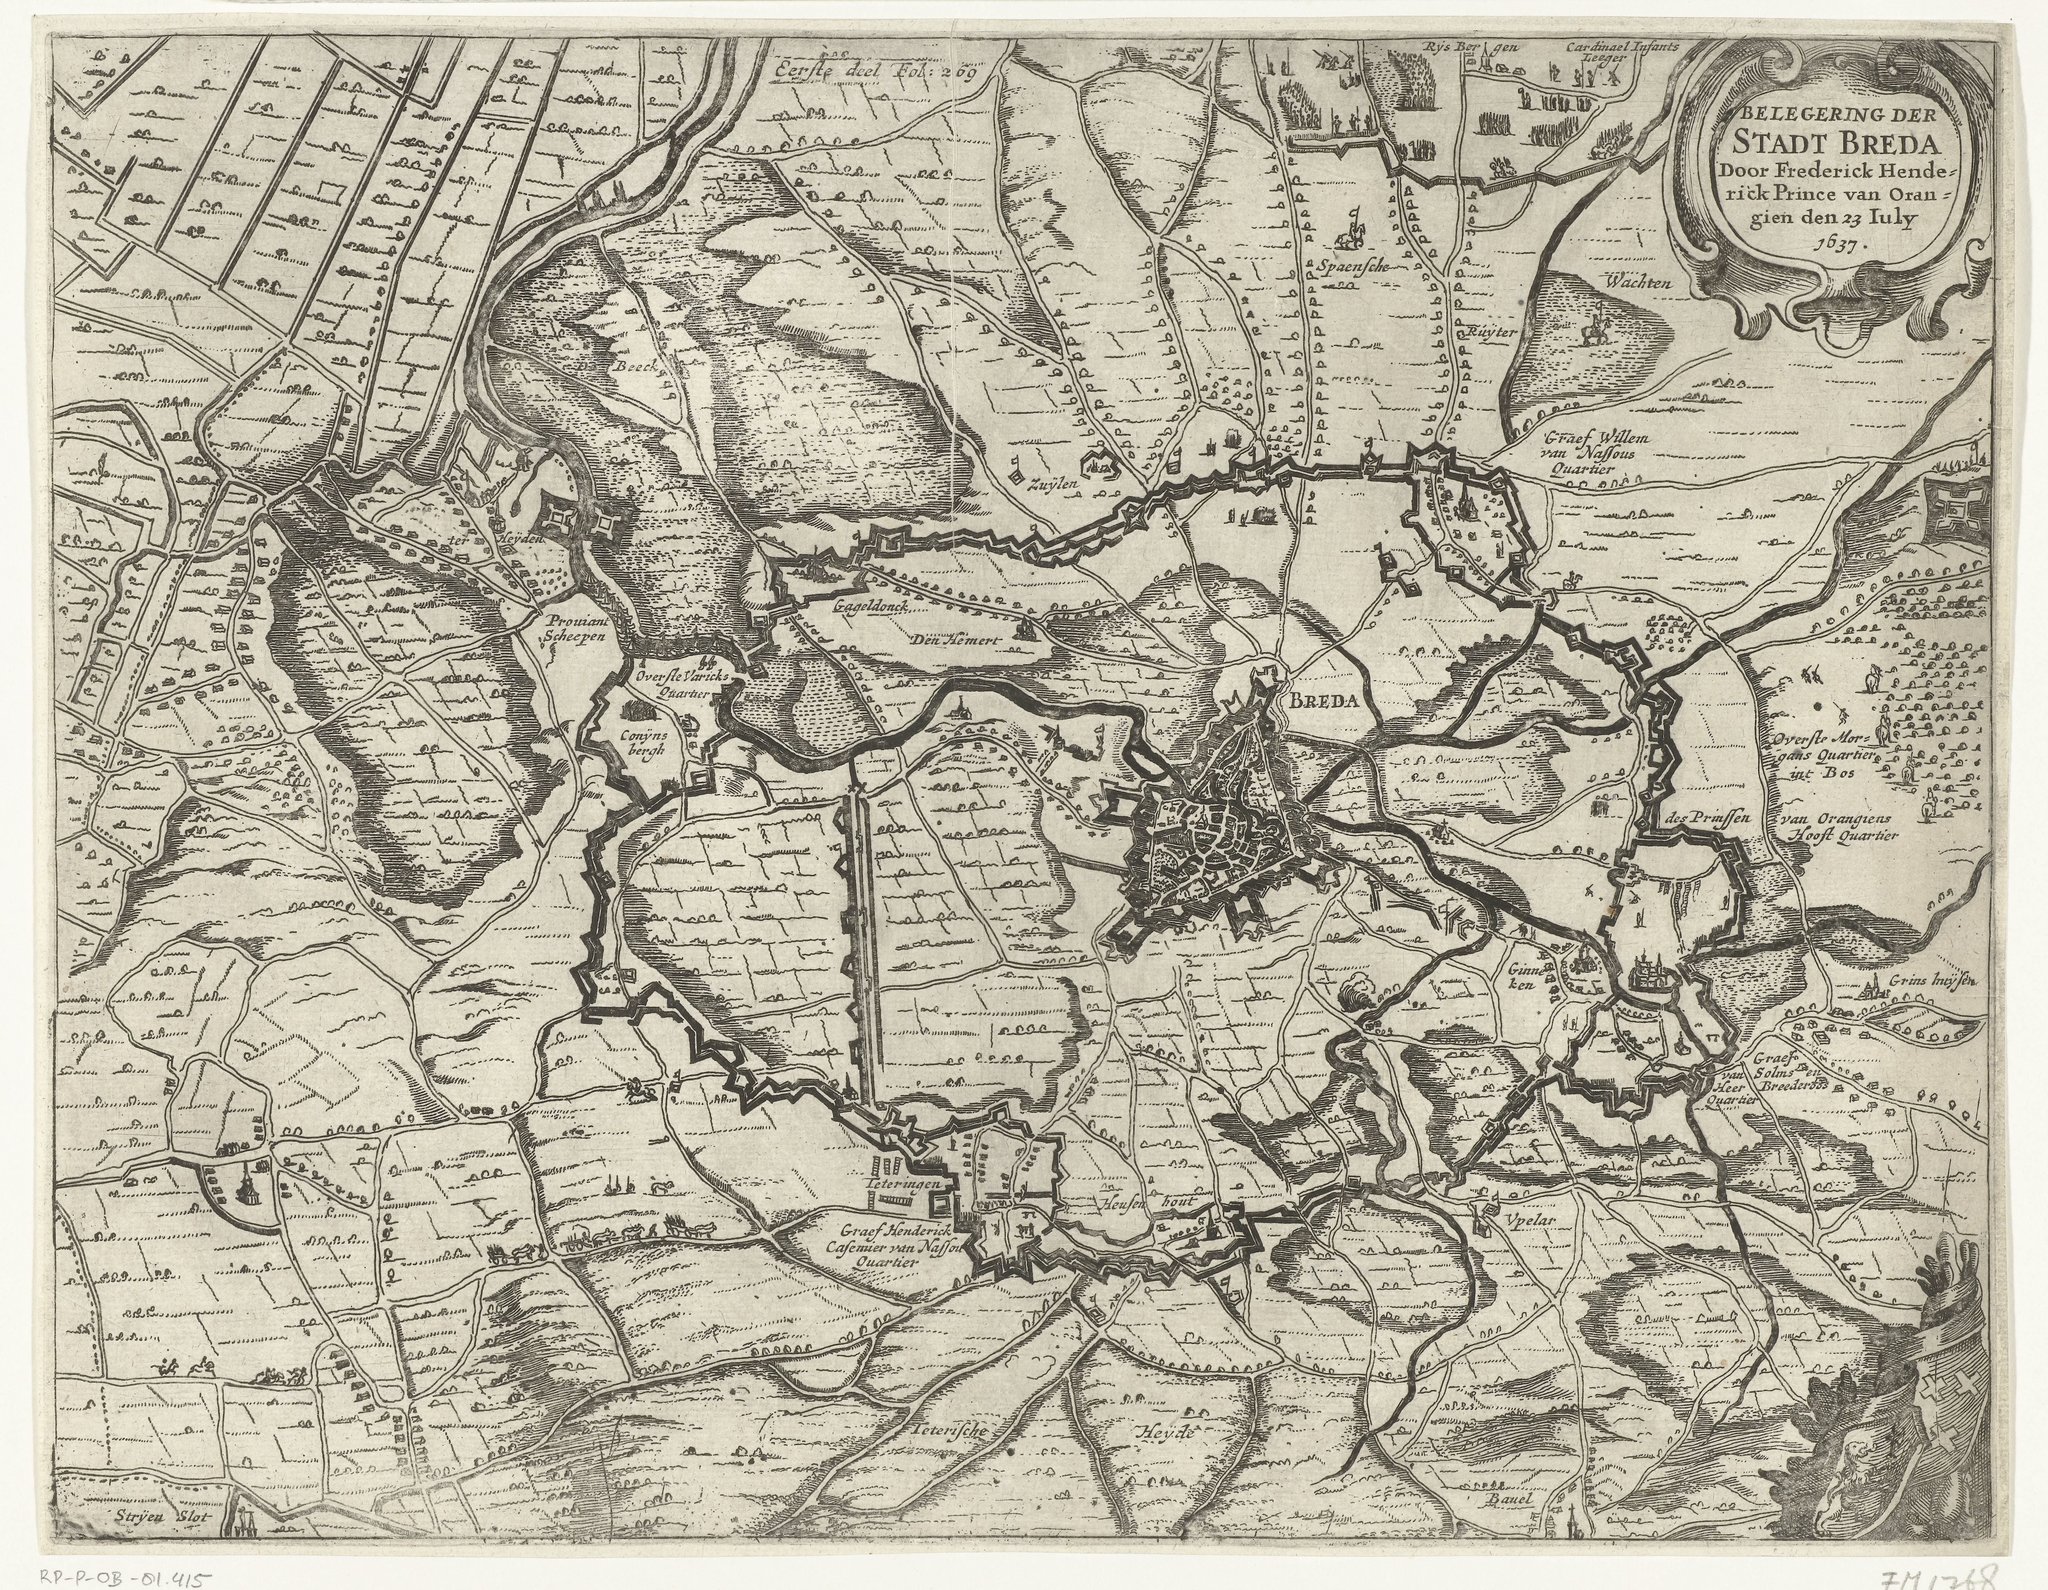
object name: history print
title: Belegering der Stadt Breda Door Frederick Henderick Prince van Orangien den 23 July 1637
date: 1651-1652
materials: paper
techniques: etching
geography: northern netherlands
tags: delft, the hague, frederick henry (prince of orange), maps of separate countries or regions, siege, position war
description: Gebruikt als illustratie in: I. Commelin, Frederick Hendrick van Nassauw prince van Orangien zyn leven en bedryf, Wed. Esdras Willemsz Snellaert en Gerrit Nieuwenhuysen, Utrecht 1652, fol. 269. Spiegelbeeldige kopie naar de prent mogelijk van P.H. Schut in de uitgave van Jodocus Janssonius van 1651 (FMH 1767) die weer gekopieerd is naar de prent van C.J. Visscher (II) (FMH 1766).